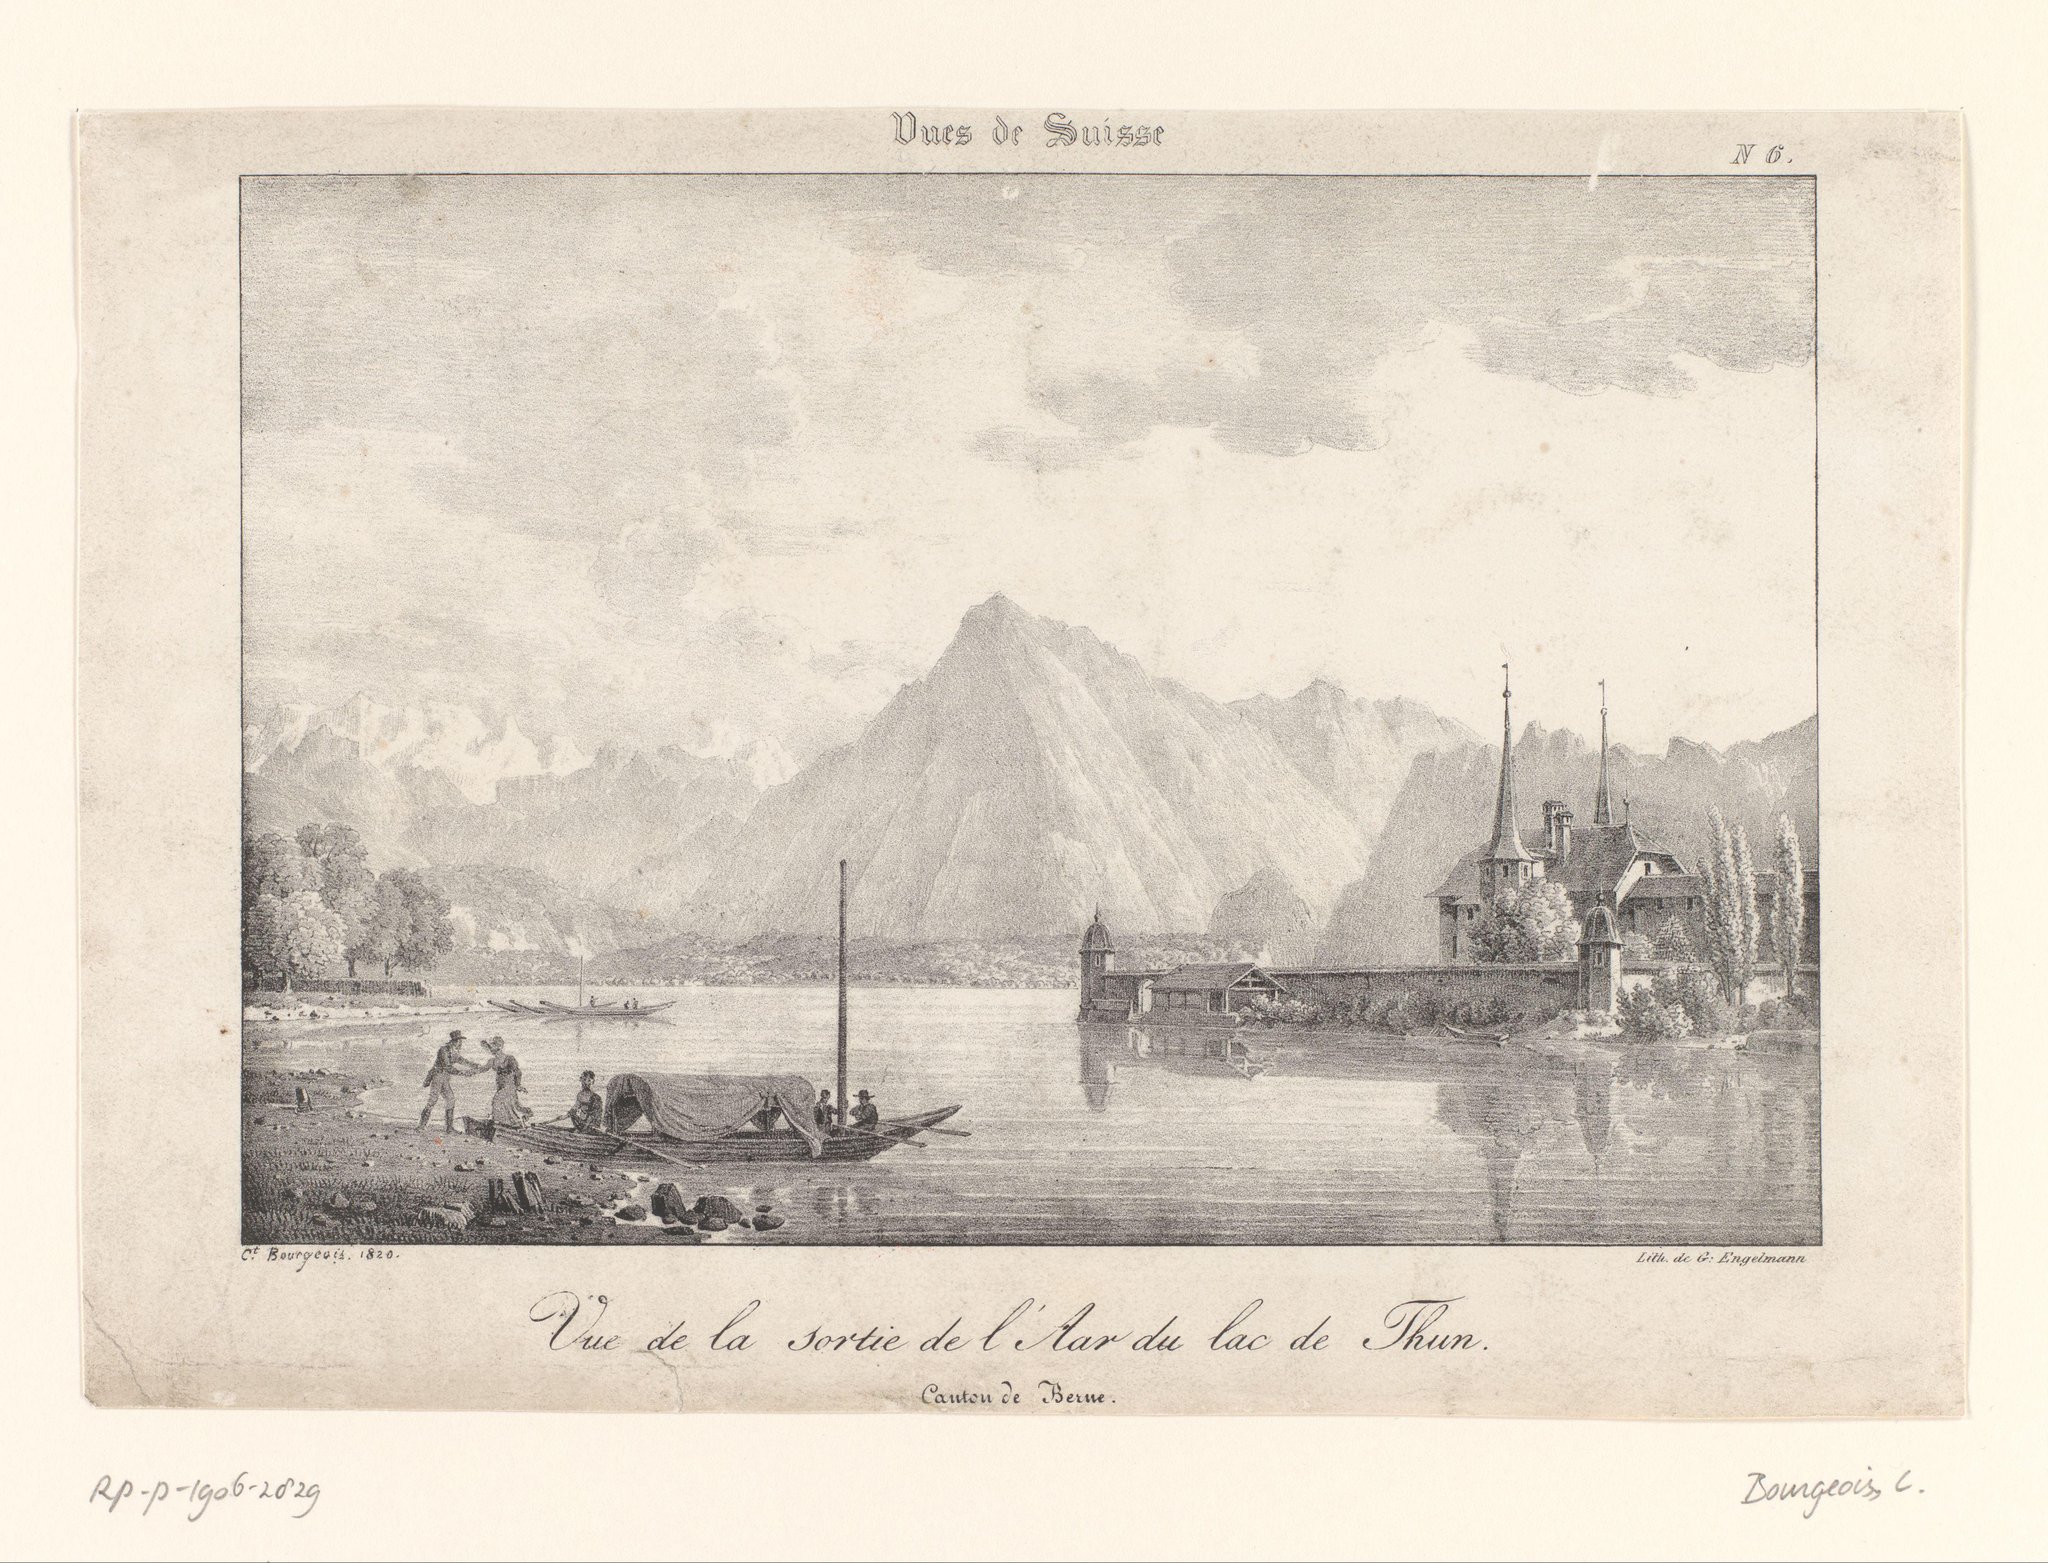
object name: print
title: Gezichten in Zwitserland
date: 1820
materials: paper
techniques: lithograph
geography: paris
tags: lake, ferry, mountains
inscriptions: collector's mark: Lugt 2228a